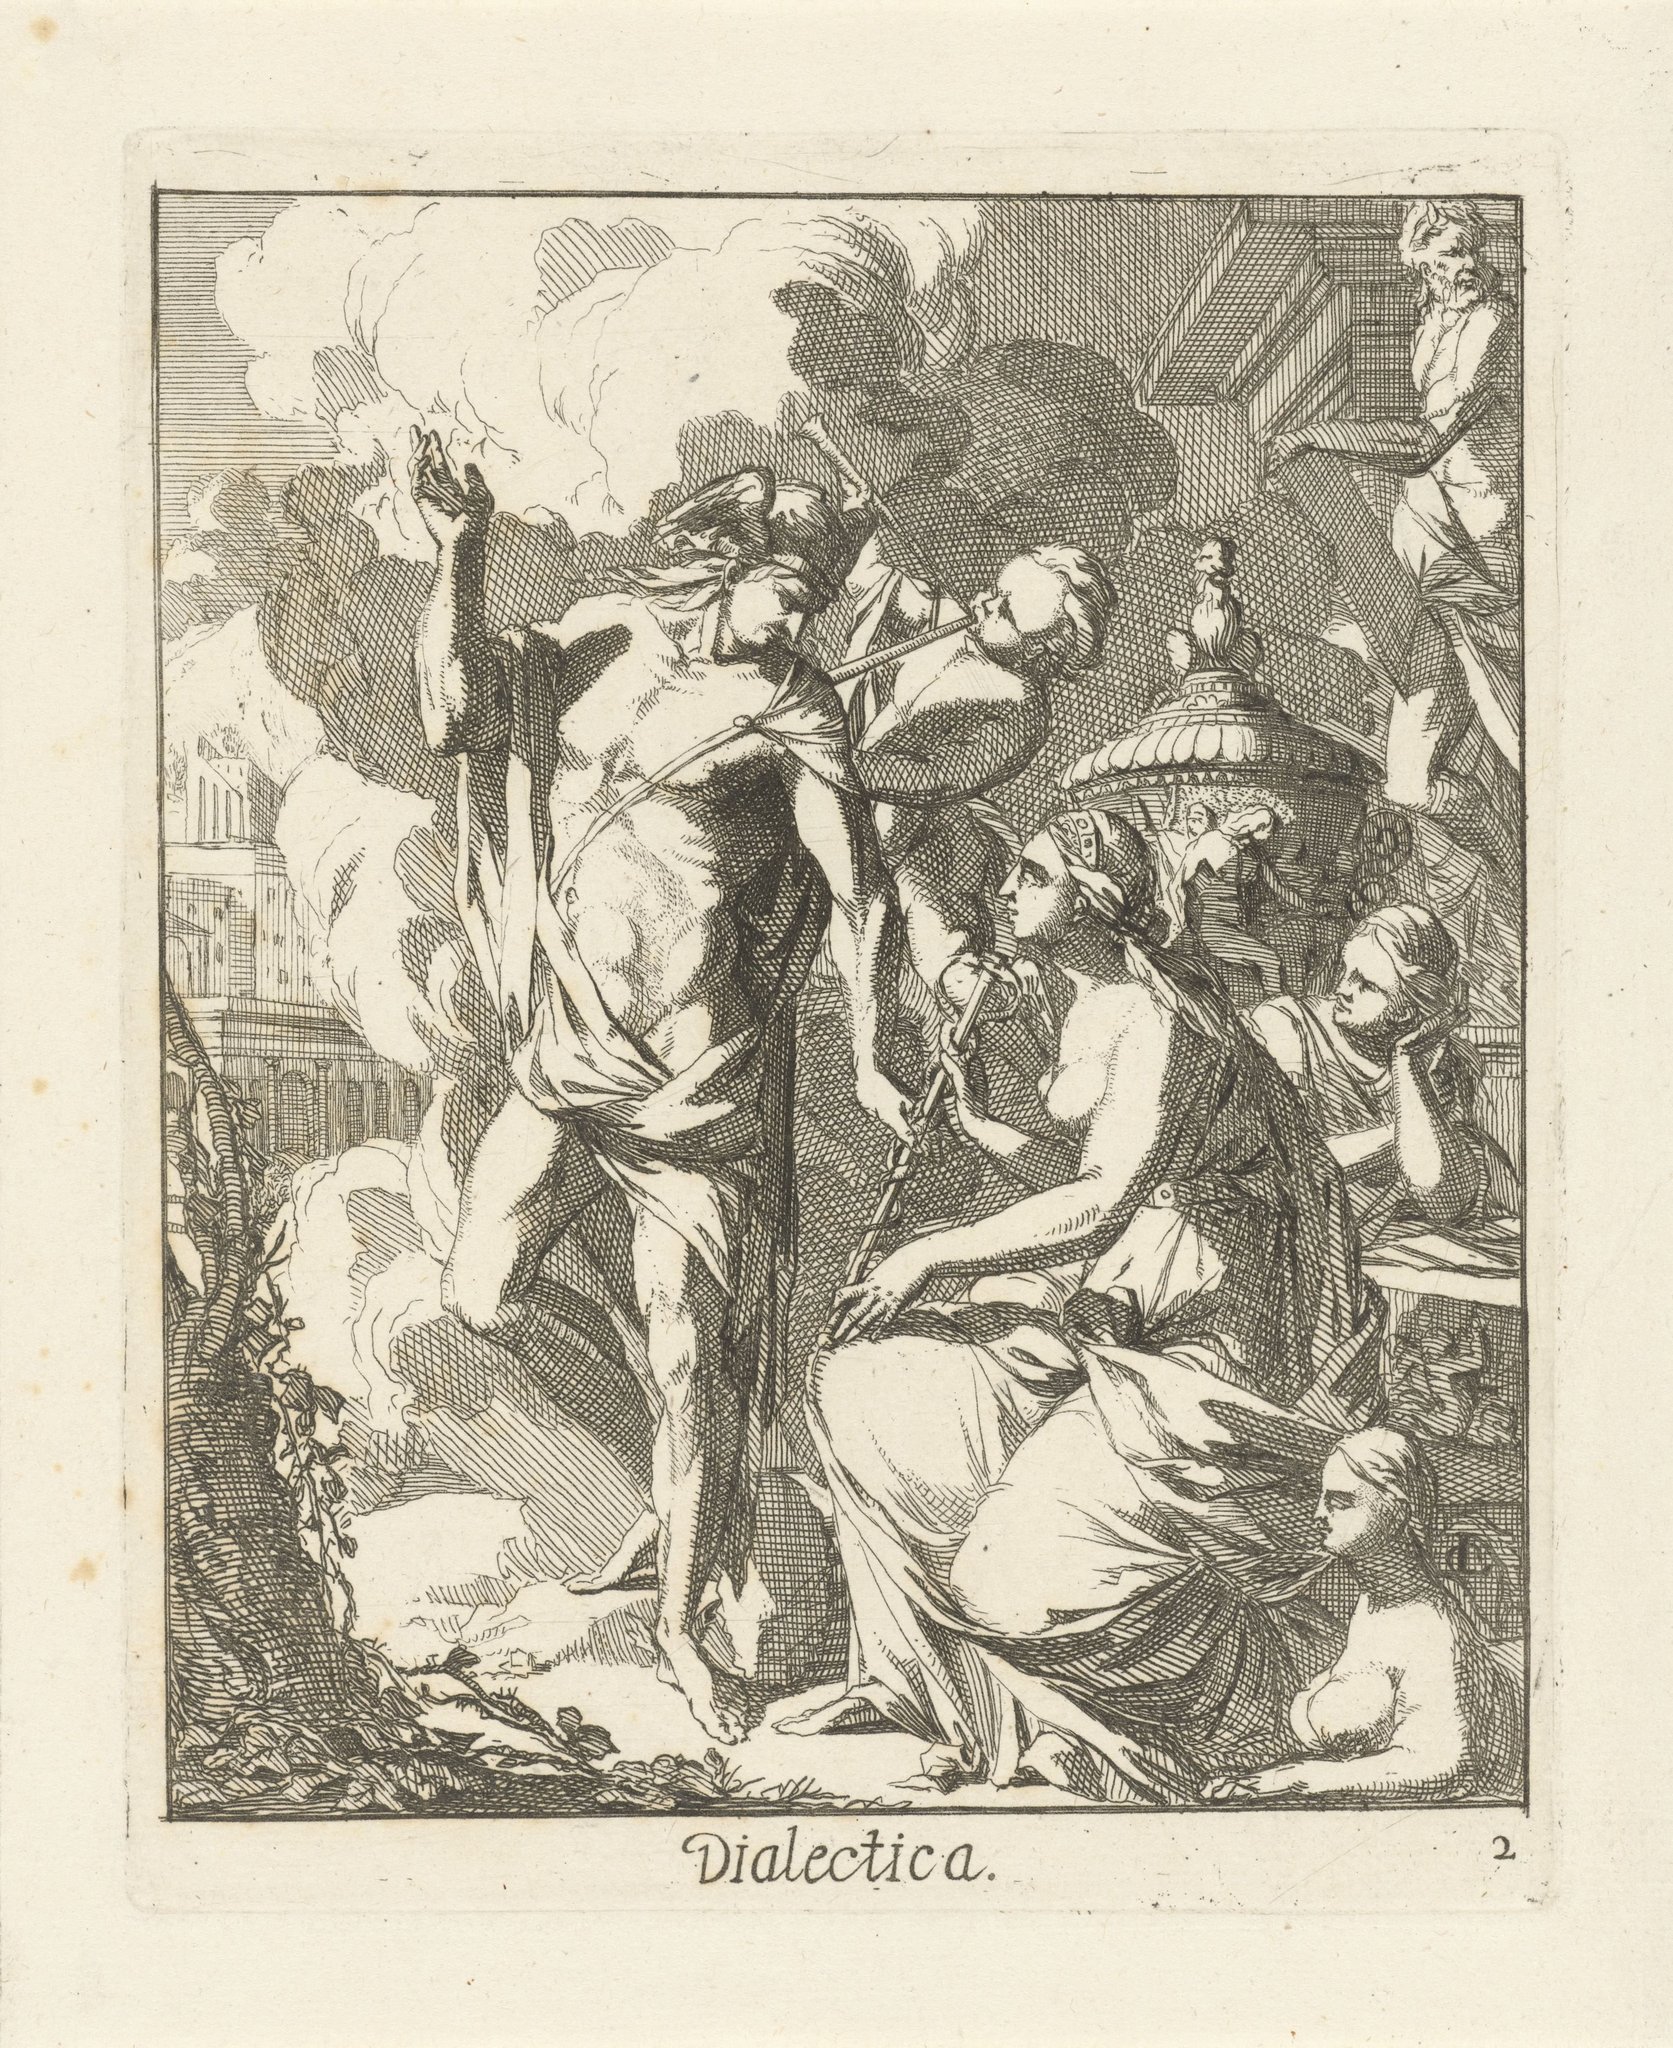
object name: print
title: Septem Artes liberales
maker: caspar luyken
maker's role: draughtsman, print maker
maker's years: 1672-1708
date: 1691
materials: paper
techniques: etching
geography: amsterdam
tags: (story of) mercury (hermes), horn, trumpet, cornet, trombone, tuba, 'dialectica' (~ trivium); 'dialettica' (ripa)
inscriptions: collector's mark: Lugt 2228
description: Mercurius, neergedaald uit een wolk, doet een mededeling aan een zittende vrouw (Dialectica). Achter hen blaast een engel op twee bazuinen.